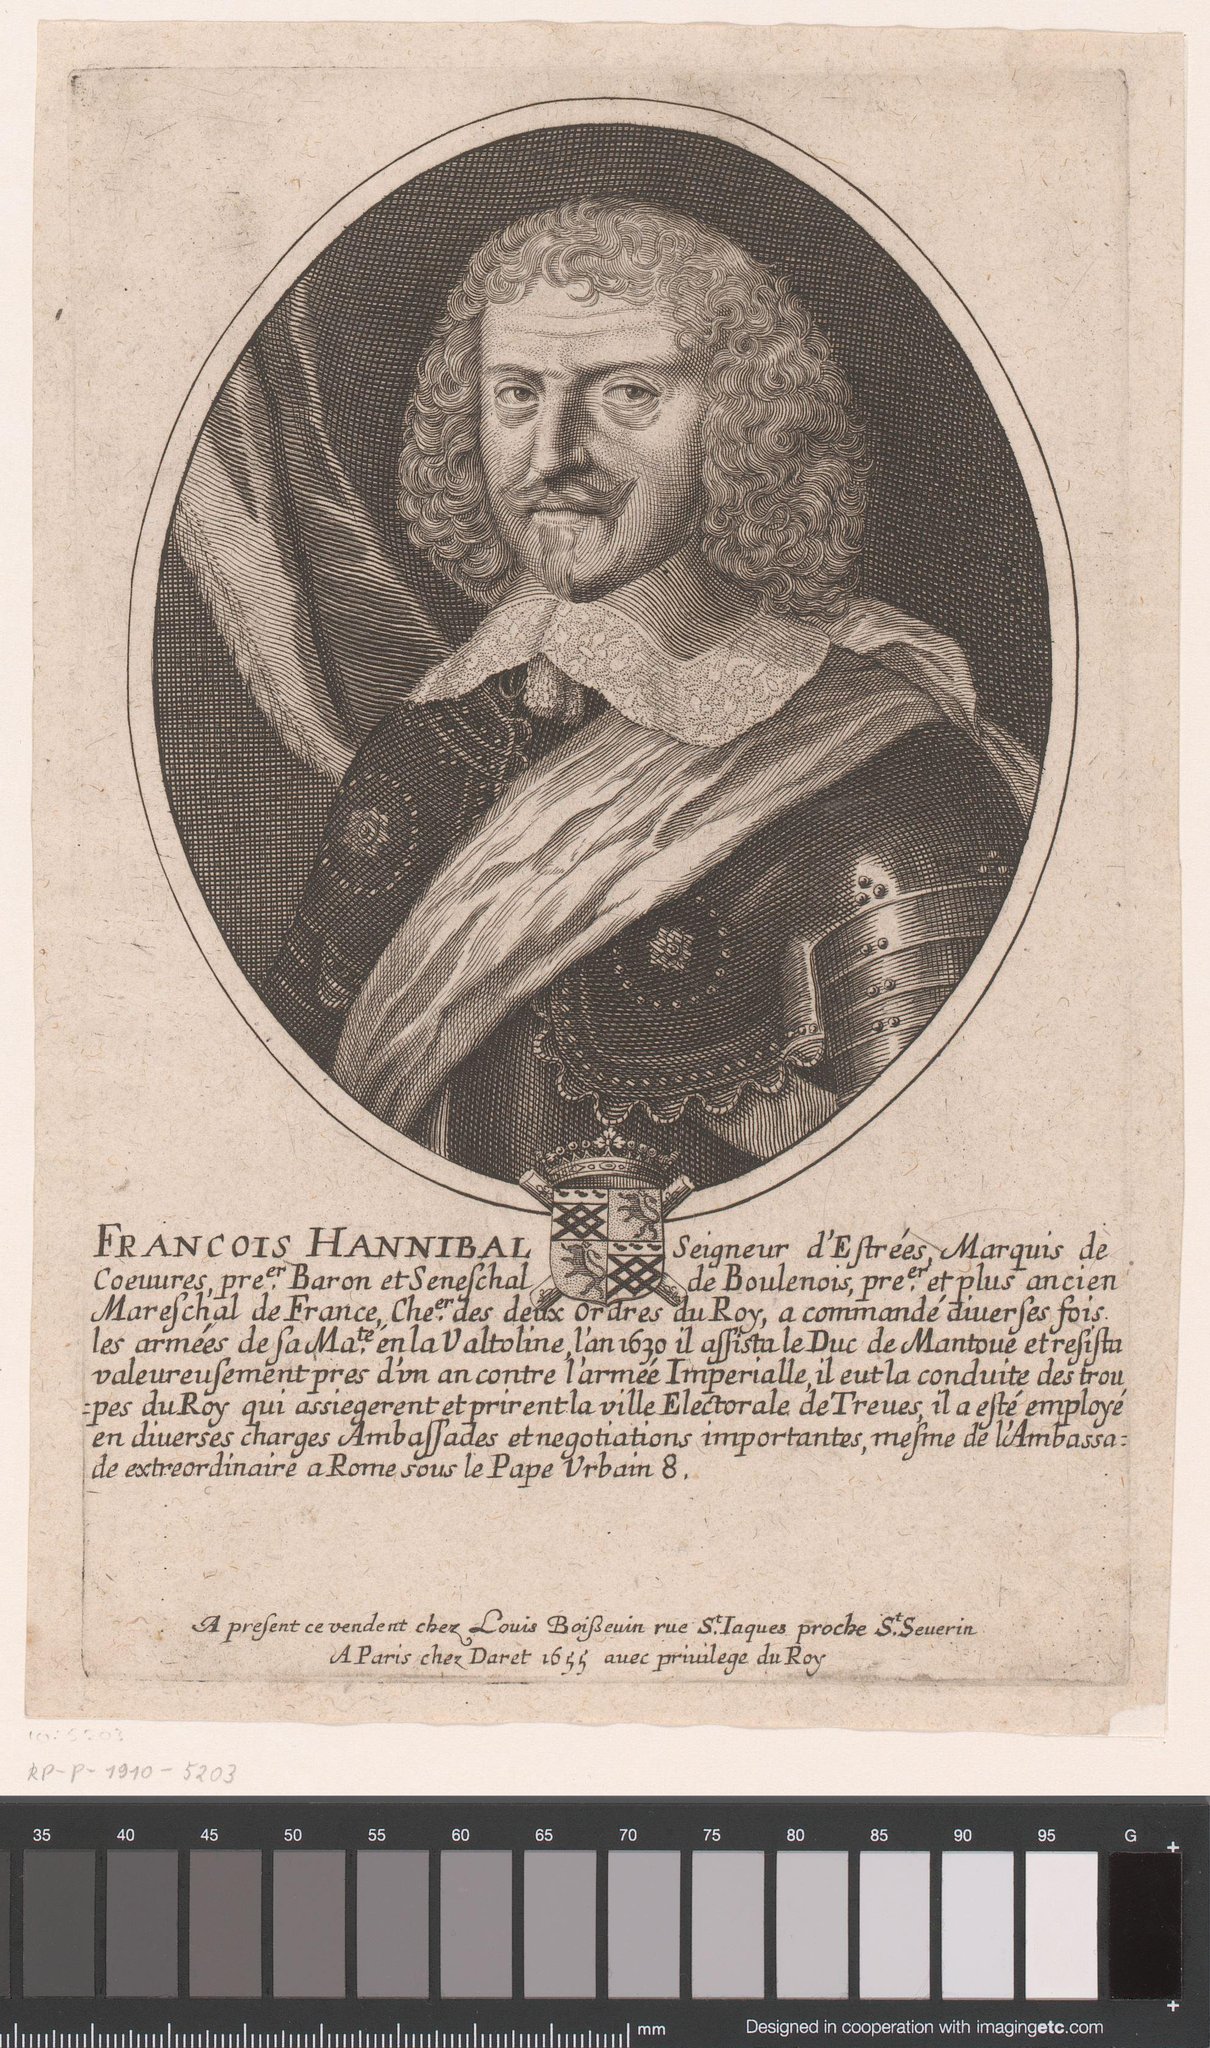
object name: print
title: Francois Hannibal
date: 1655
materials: paper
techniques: engraving, etching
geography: paris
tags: paris, ornament ~ medallion, historical persons, armorial bearing, heraldry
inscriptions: collector's mark: Lugt 2228